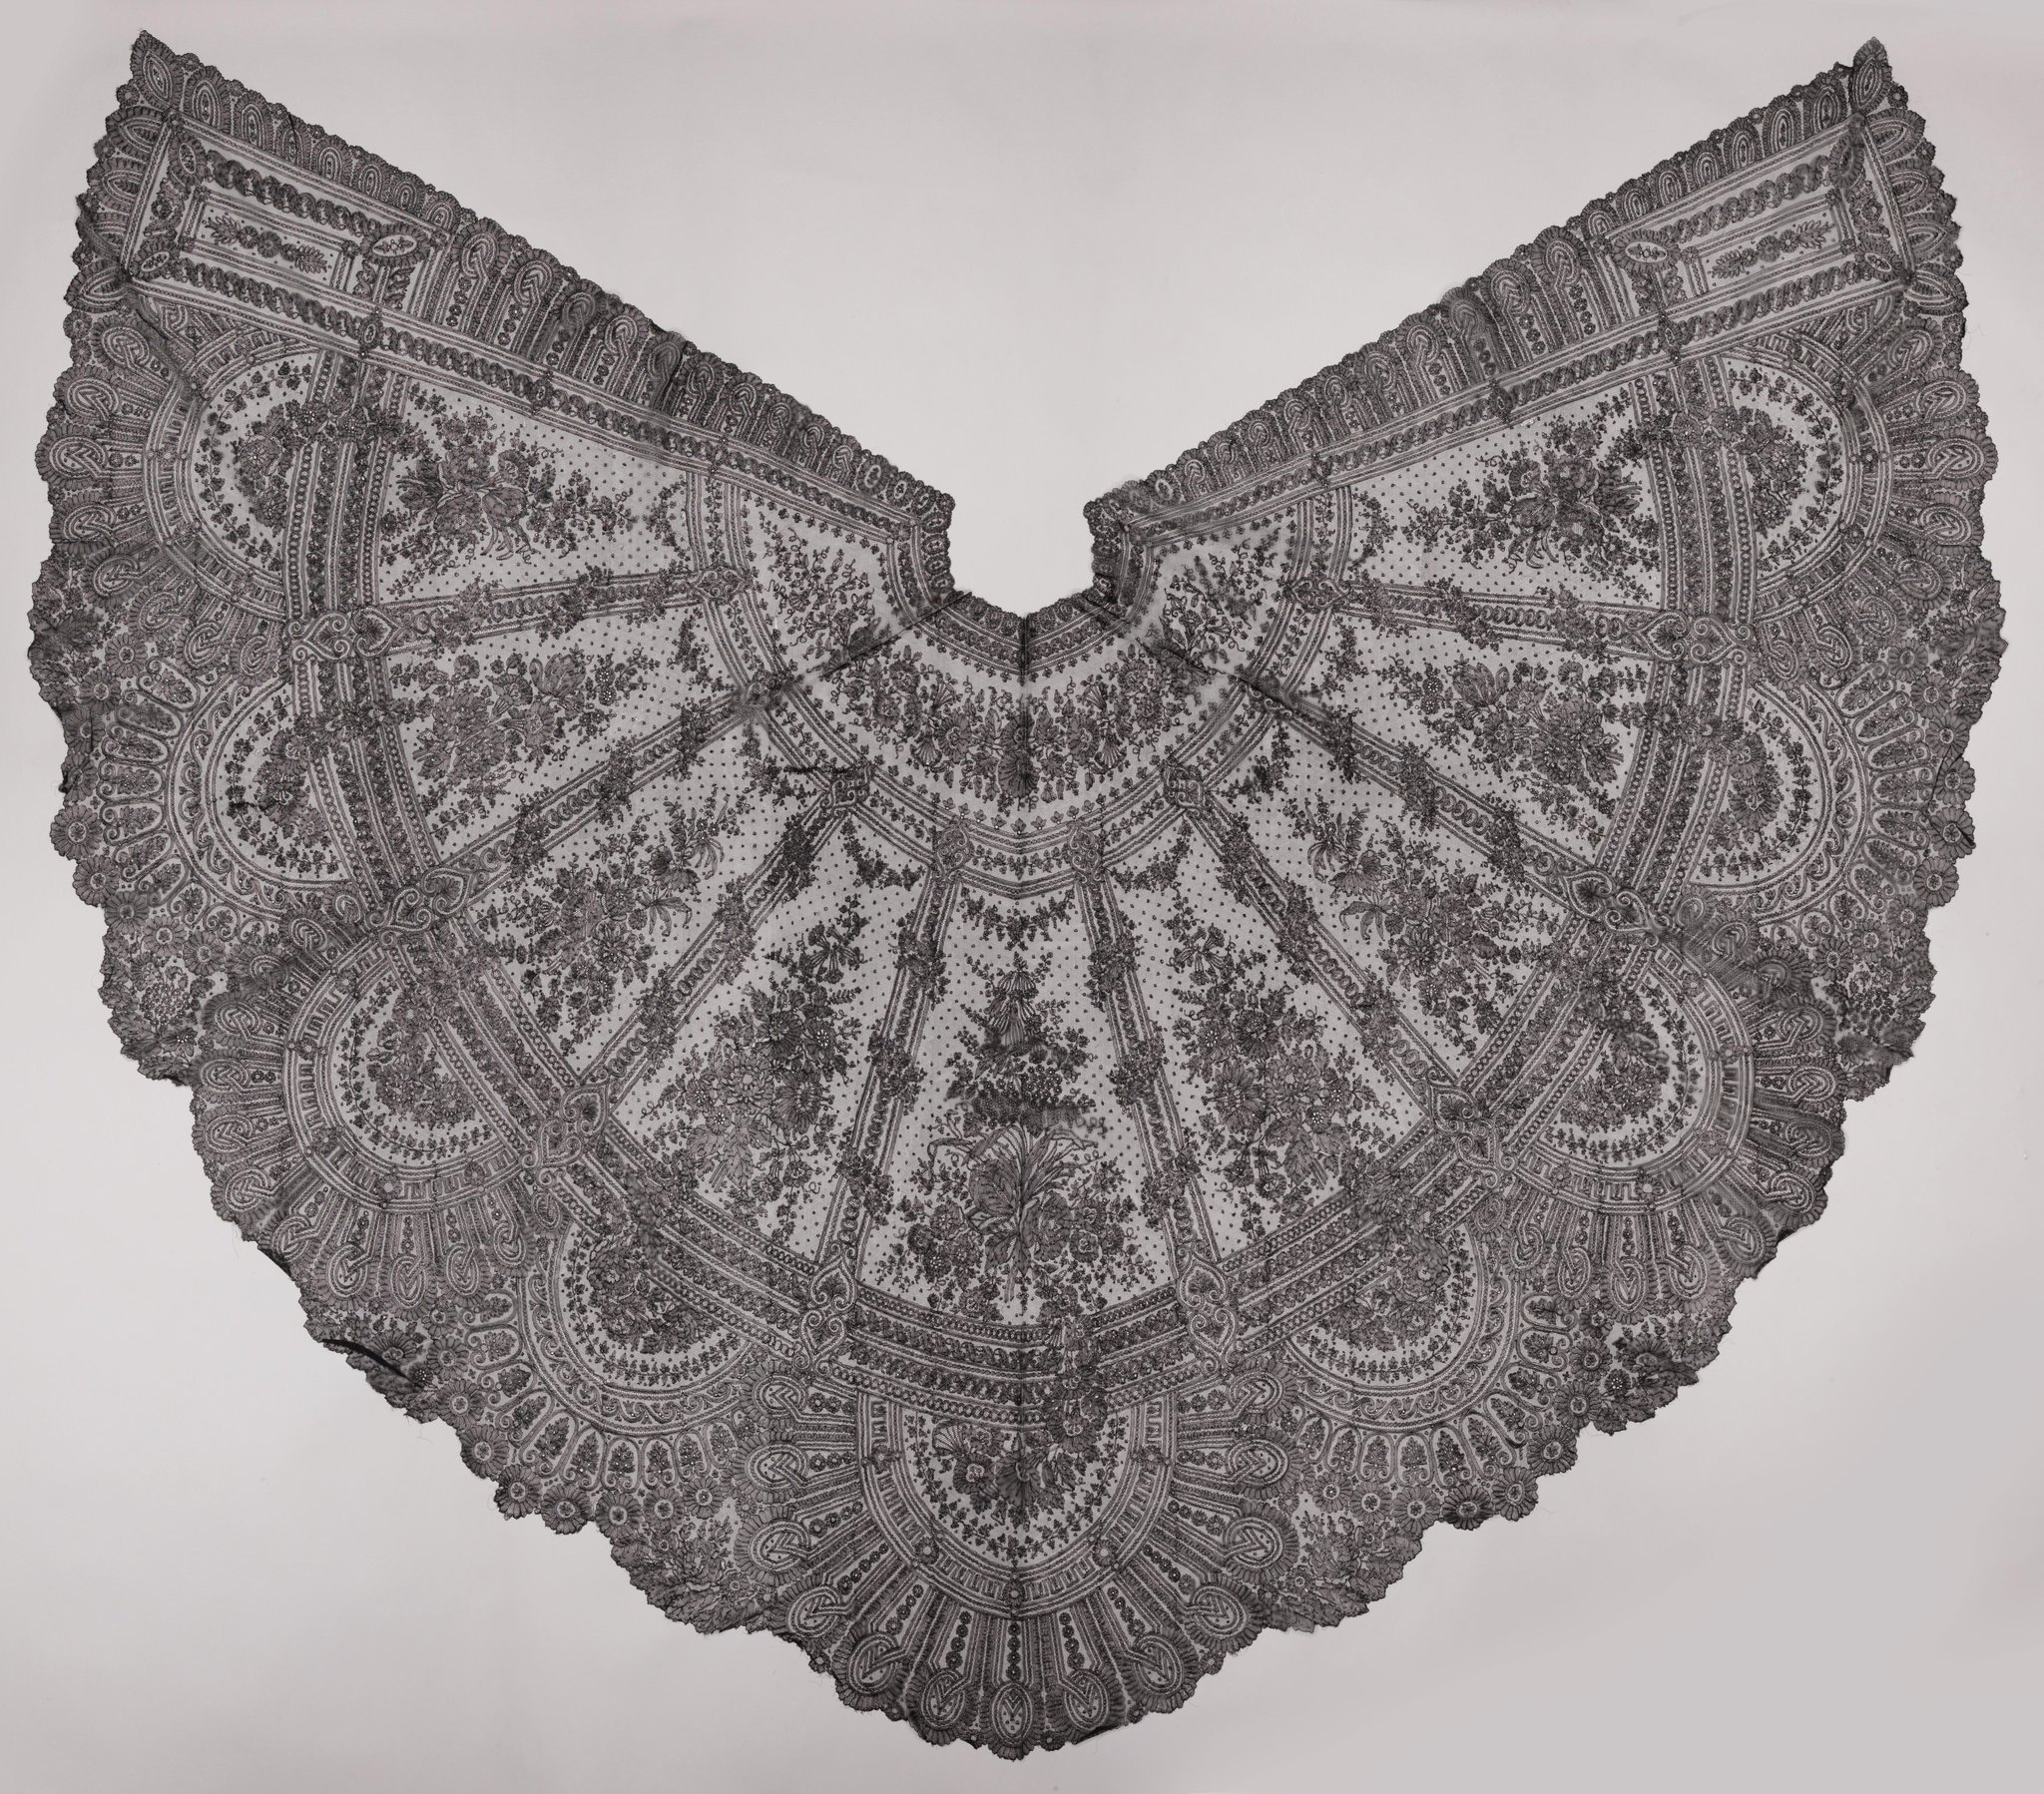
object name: cloak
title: Cape van kloskant met de pergola met omwonden zuiltjes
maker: Anonymous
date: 1860-1880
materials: silk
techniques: lace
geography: belgium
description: Cape van zwarte kloskant: Chantilly-kant. Een waaiervormig model met verlengde punt is ingedeeld in een kraagstuk, een middenstuk, een pergola met acht zuiltjes en een rand van pauwenstaartvormige schulpen. Een tamelijk grove traliegrond is alleen in het kraagstuk leeg, maar overigens bezaaid met moesjes. Het kraagstuk is versierd met een gesloten guirlande van winde. De pergola vertoont zuiltjes, die met slingers zijn omwonden en een binnendecor van hoge, driehoekige boeketten, die ten opzichte van de middelste en grootste boeket symmetrisch zijn geschikt. Hiervan hangen bloemkransen af, waar het terras van de pergola dwars doorheen loopt. De schulpen zijn meer dan een halve cirkel diep en afwisselend gevuld met uitstralende, dooreengevlochten puntige en ovale schakels en met palmetten, vergezeld van een margriet. Kleine binnenschulpen bestaan uit een boeket met hangende eikebladerenrand. Langs de sluiting een dwarsrij van gevlochten schakels.